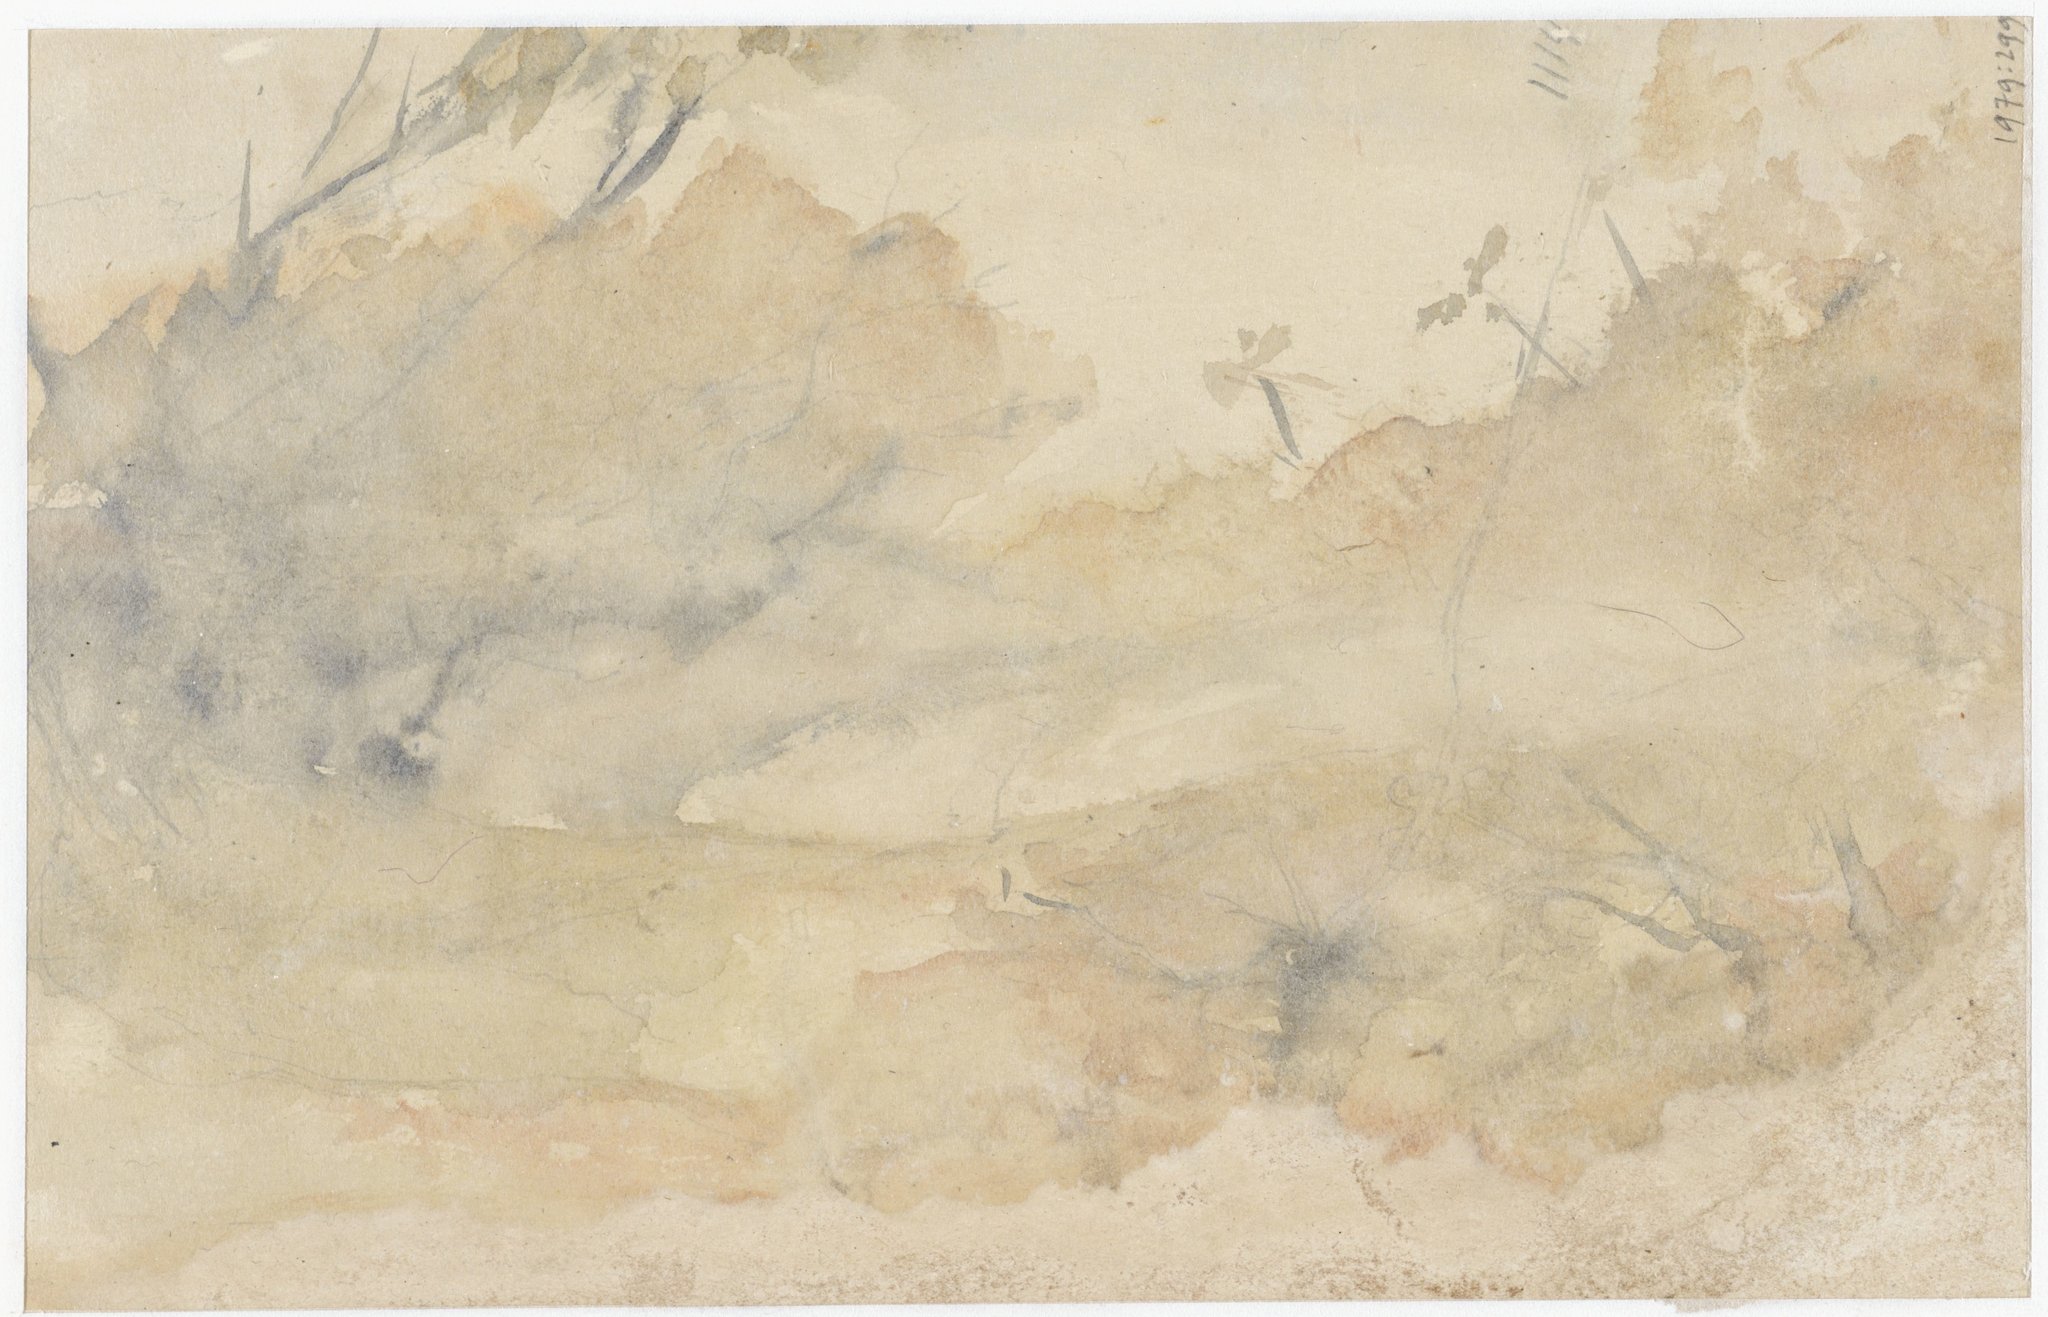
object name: watercolor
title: Landschap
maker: jozef israëls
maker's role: draughtsman, painter, print maker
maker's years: 1824-1911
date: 1834-1911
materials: paper, pencil, watercolor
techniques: brush